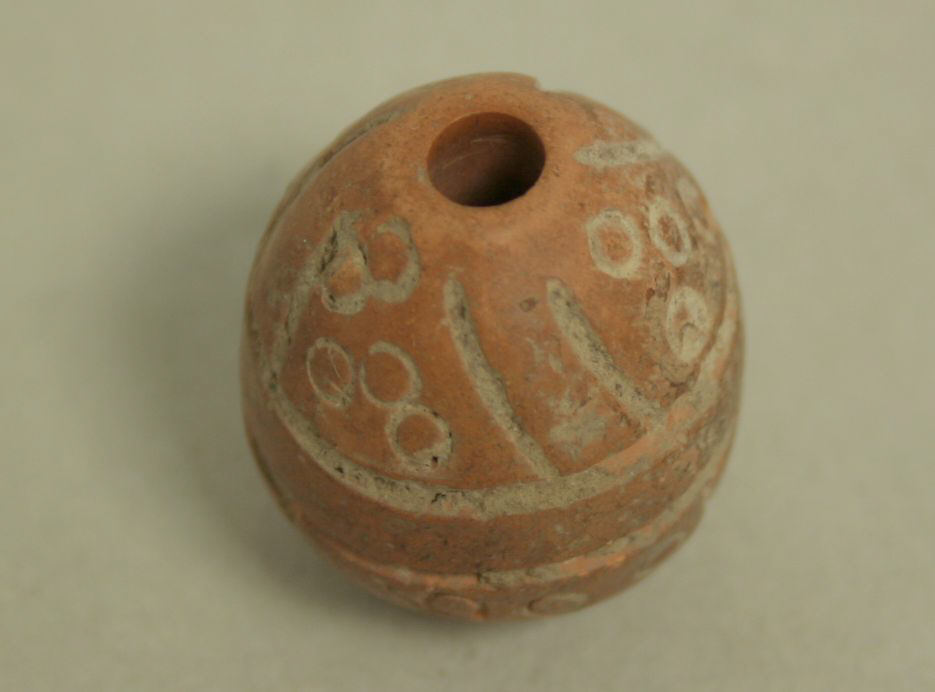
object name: spindle whorl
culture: peruvian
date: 1-500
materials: ceramic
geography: peru